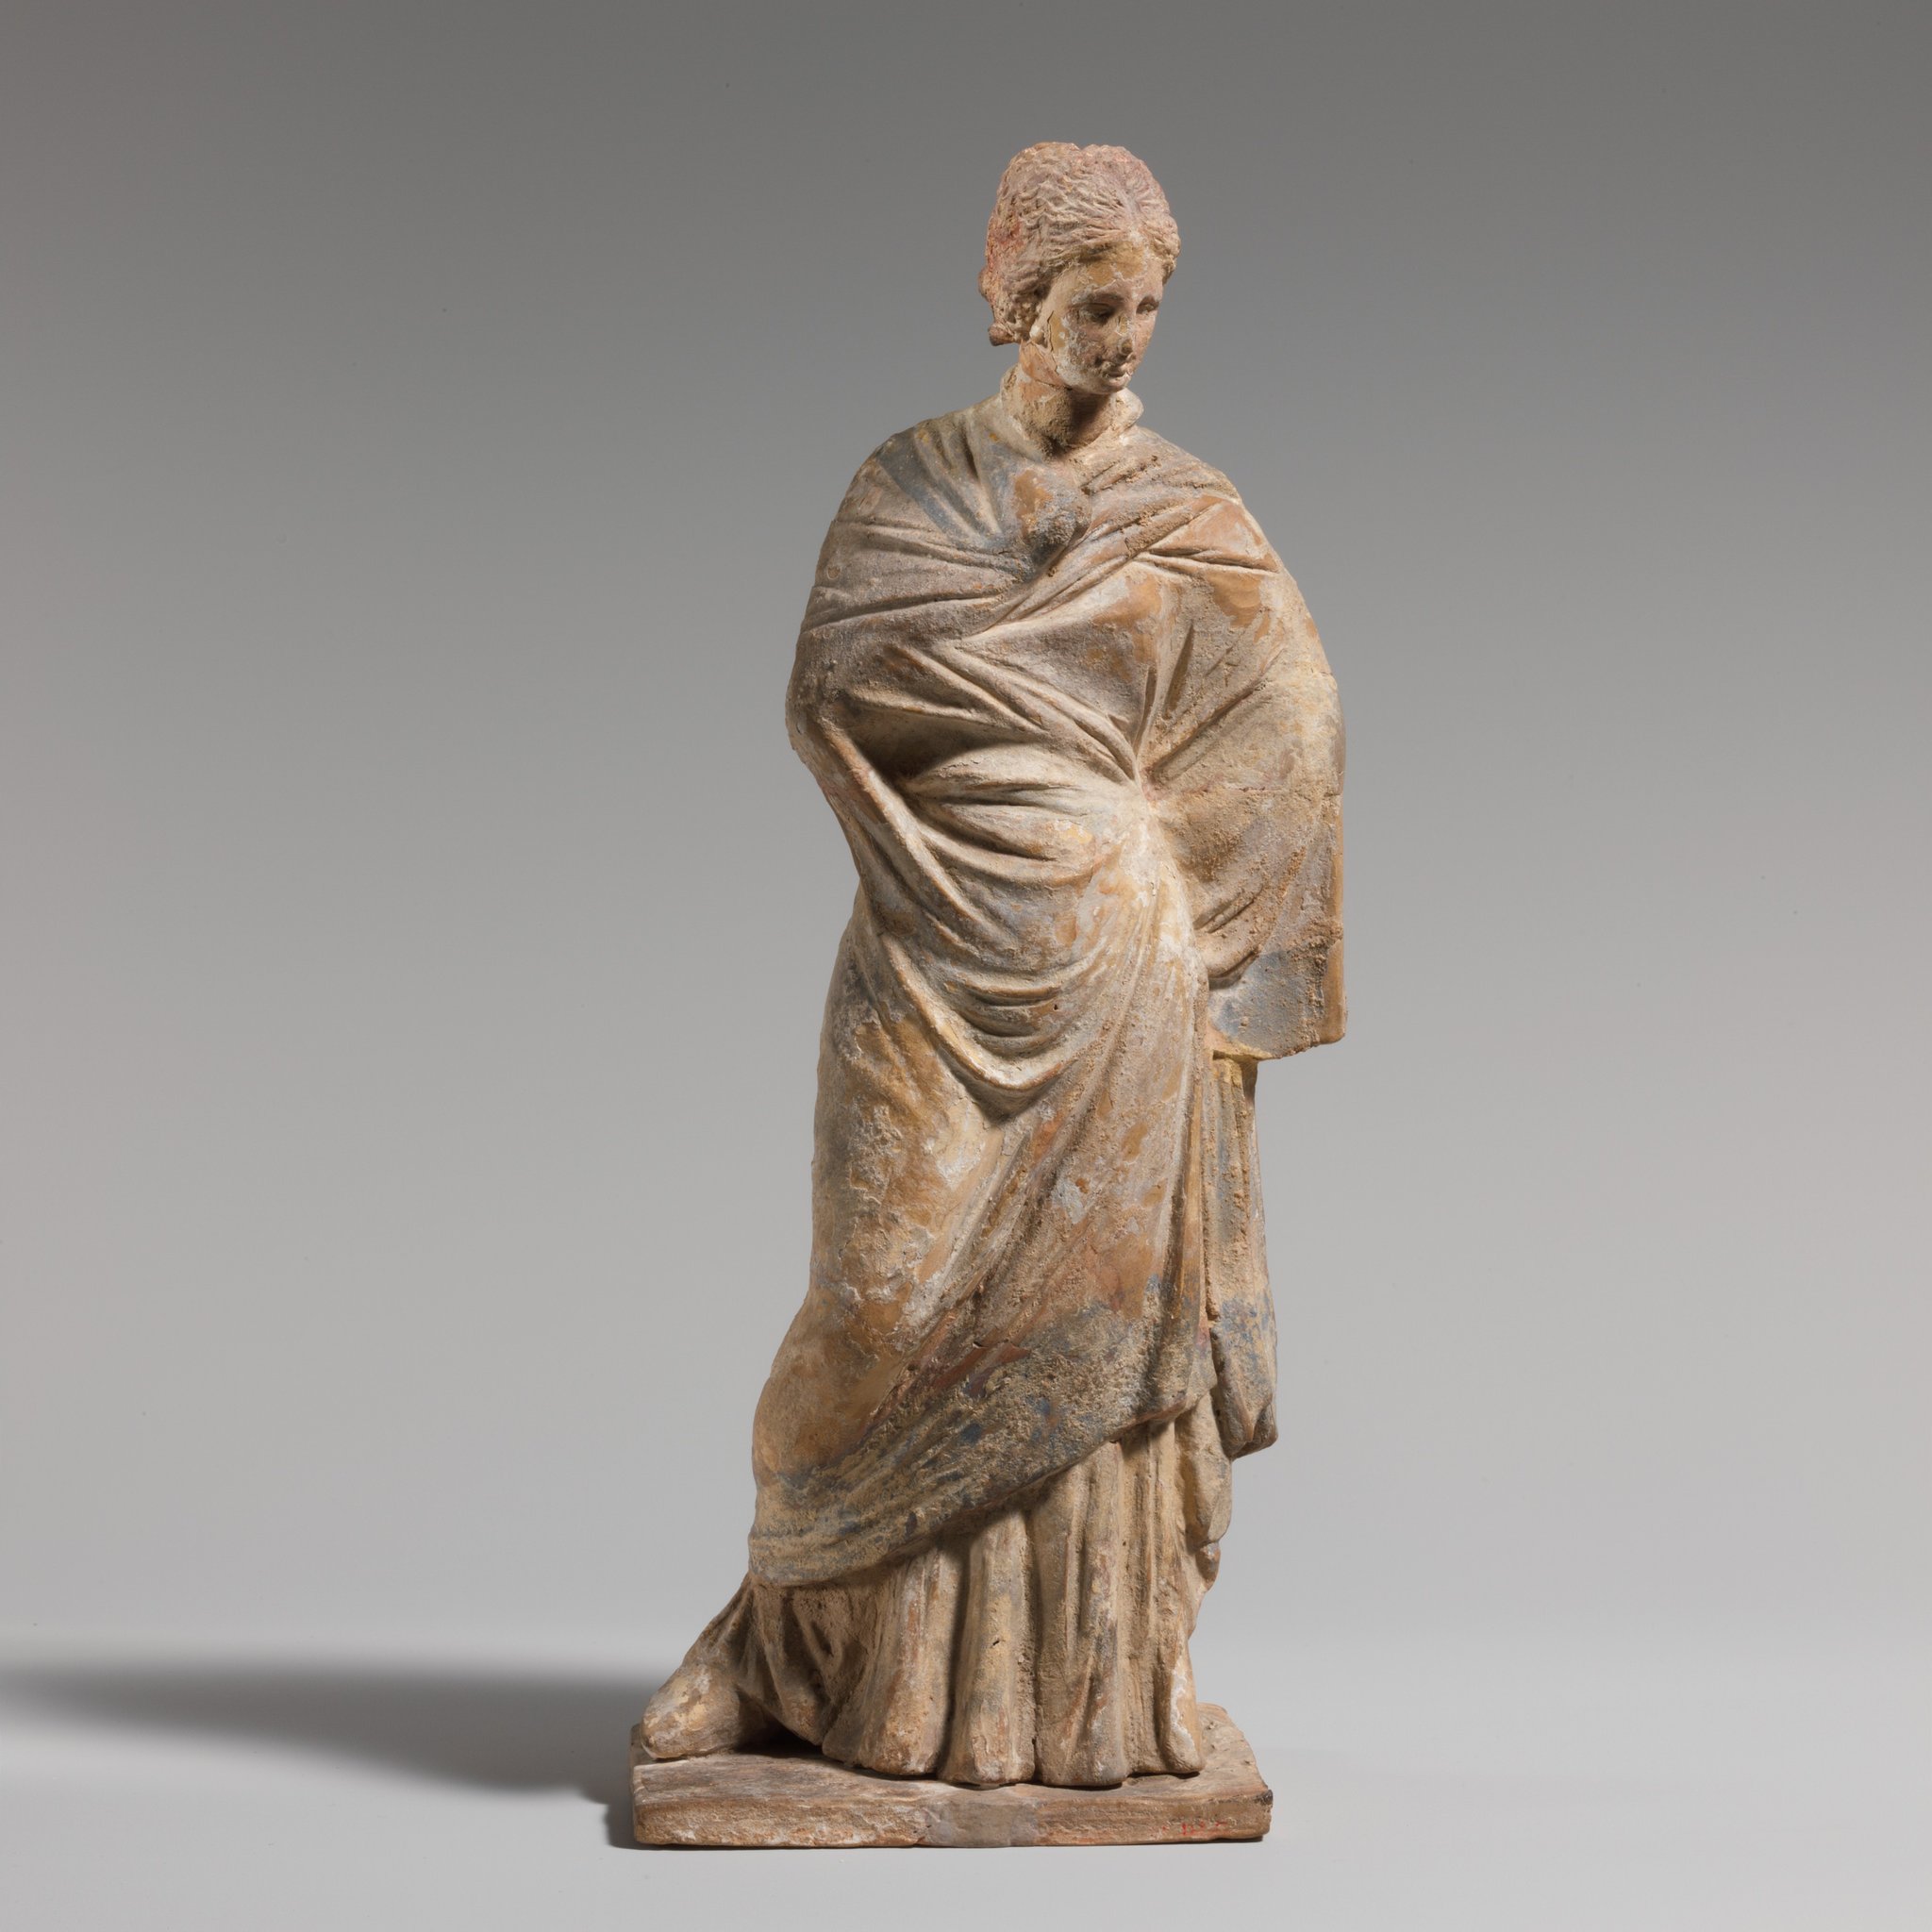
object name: statuette of a woman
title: Terracotta statuette of a woman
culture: greek, boeotian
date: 300-268 BCE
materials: terracotta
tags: women